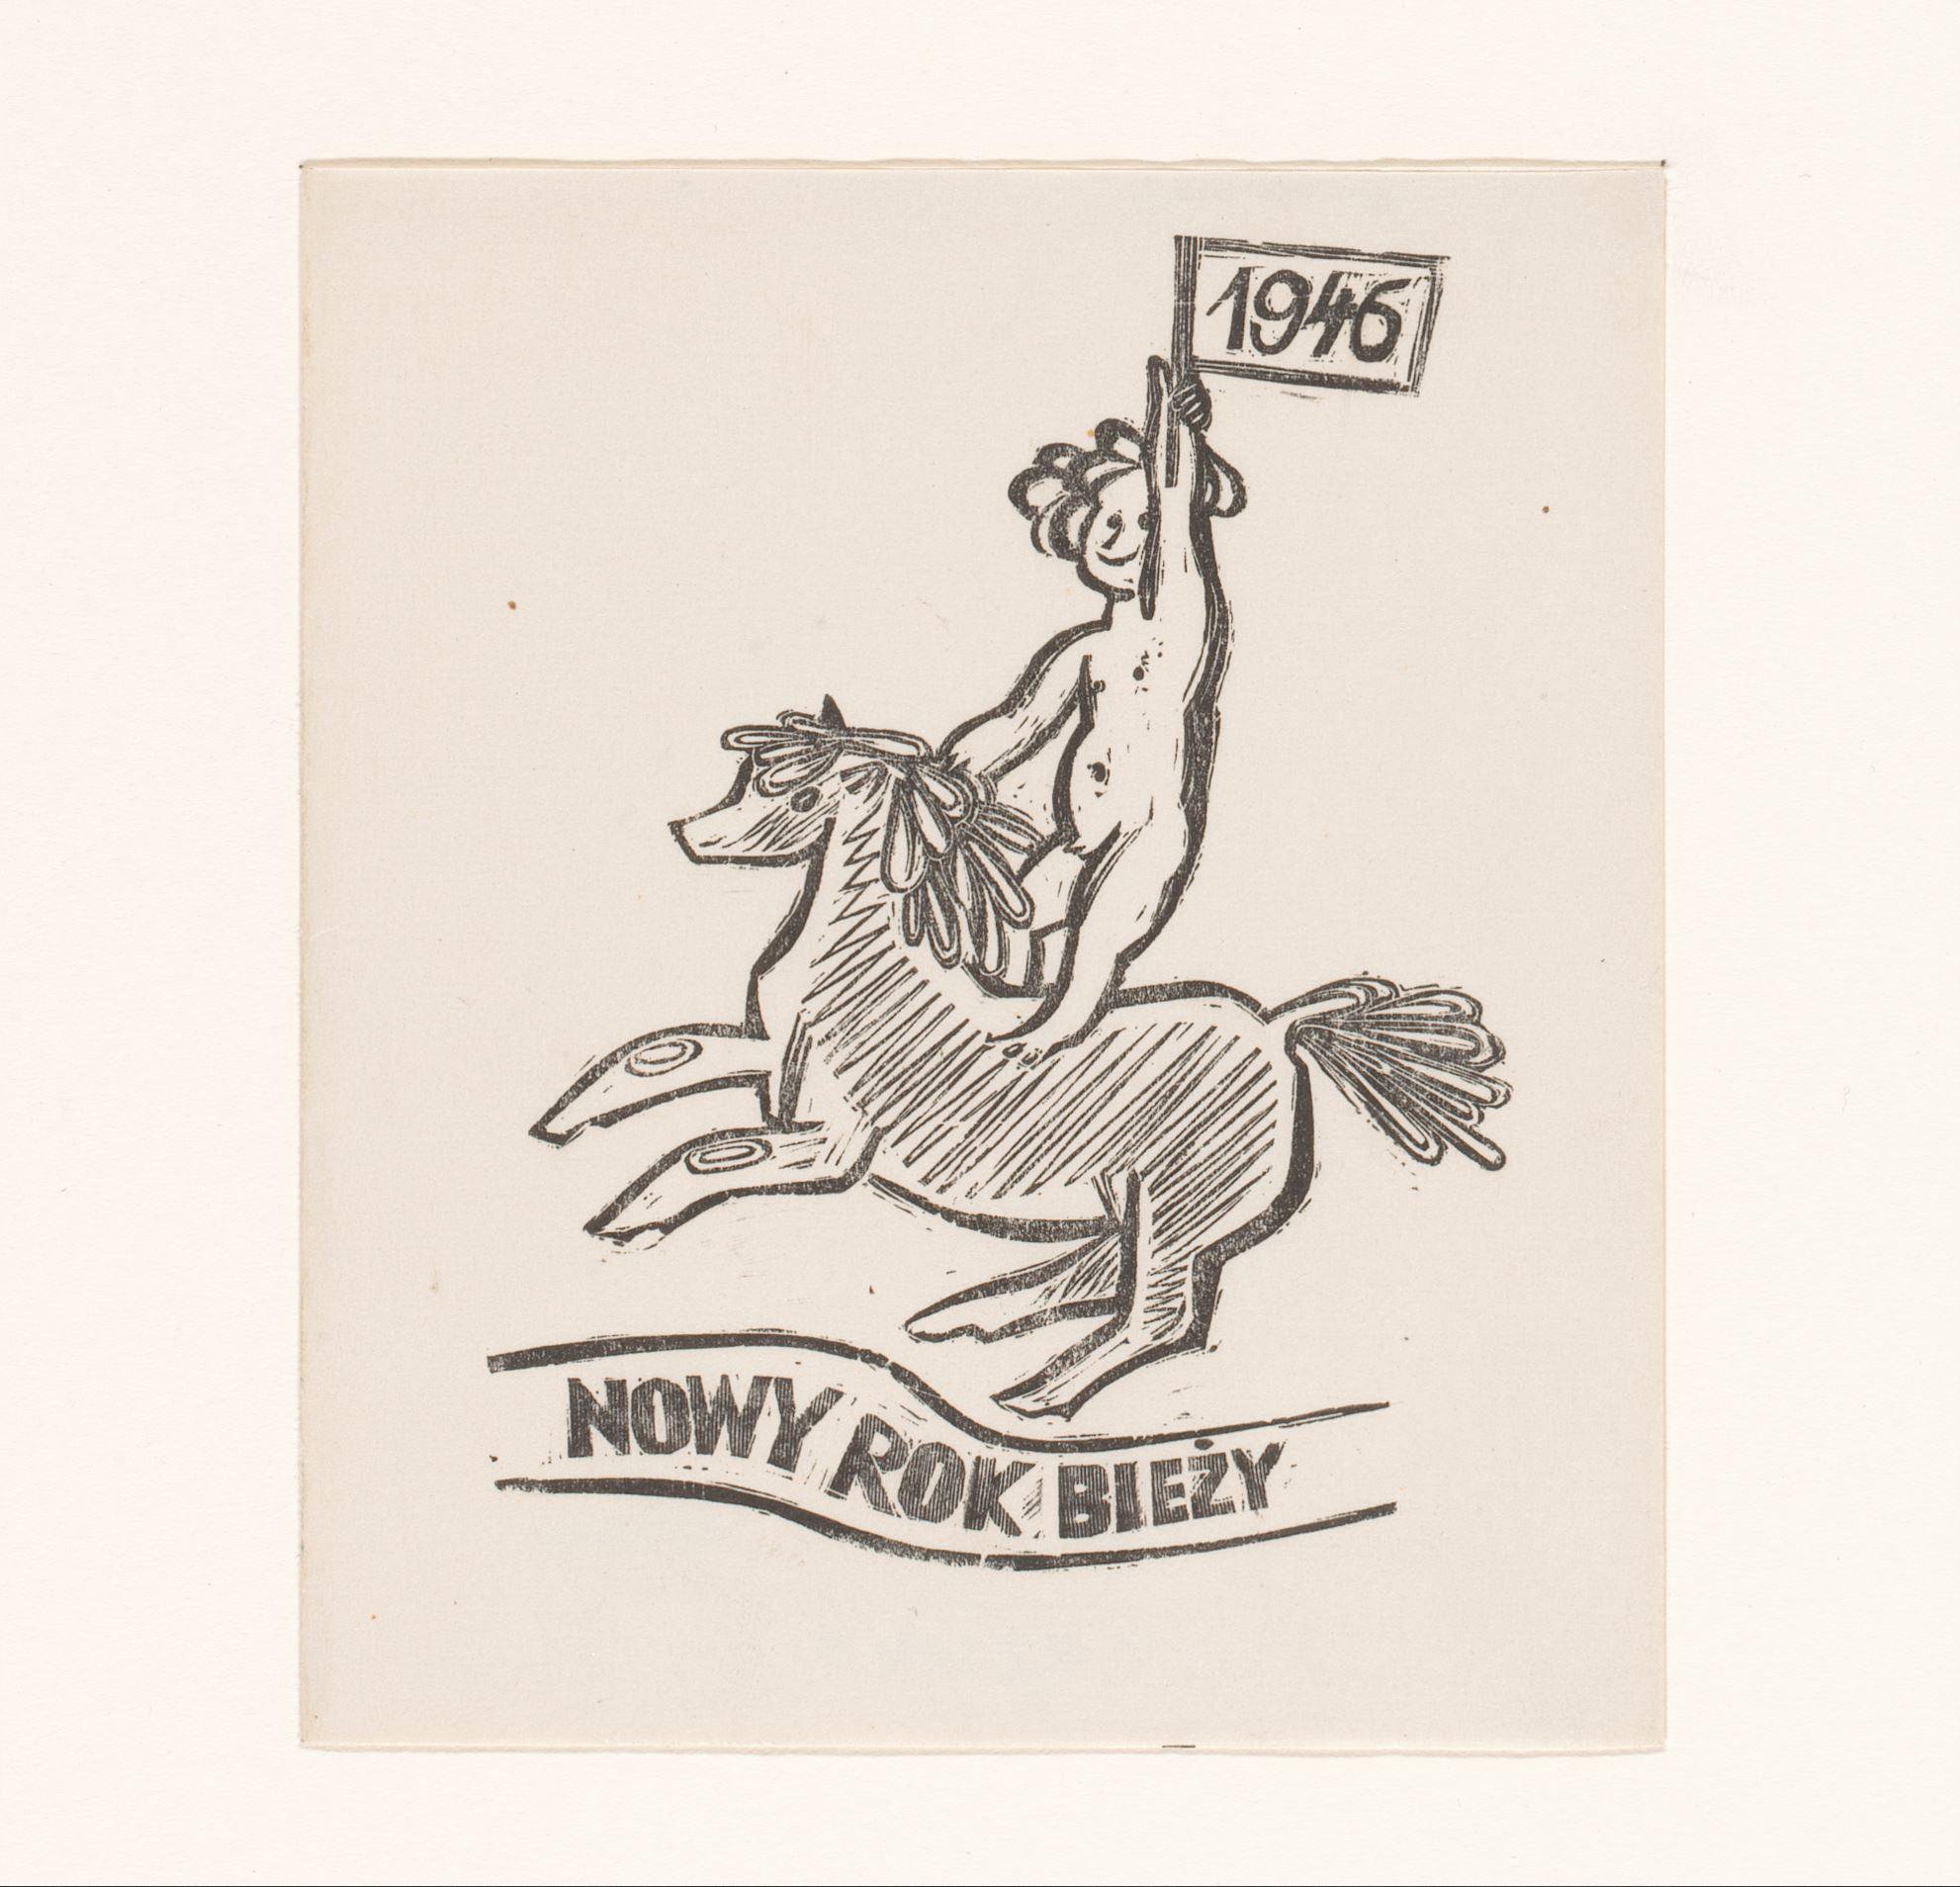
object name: print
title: Maria met Christus en drie duiven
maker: ad. hoffmann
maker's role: print maker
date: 1900-1947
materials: paper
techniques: woodcut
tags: madonna: mary sitting or enthroned, the christ-child in her lap (or in front of her bosom) (mary sometimes represented half-length)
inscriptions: annotation, n: ‘oryg. dnow.’, collector's mark: Lugt 2228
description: Geboorte- en sterfdatum van de prentmaker zijn onbekend. Daarom is voor de bepaling van de rechten van dit object gebruik gemaakt van de verwervingsdatum Rijksmuseum Amsterdam.